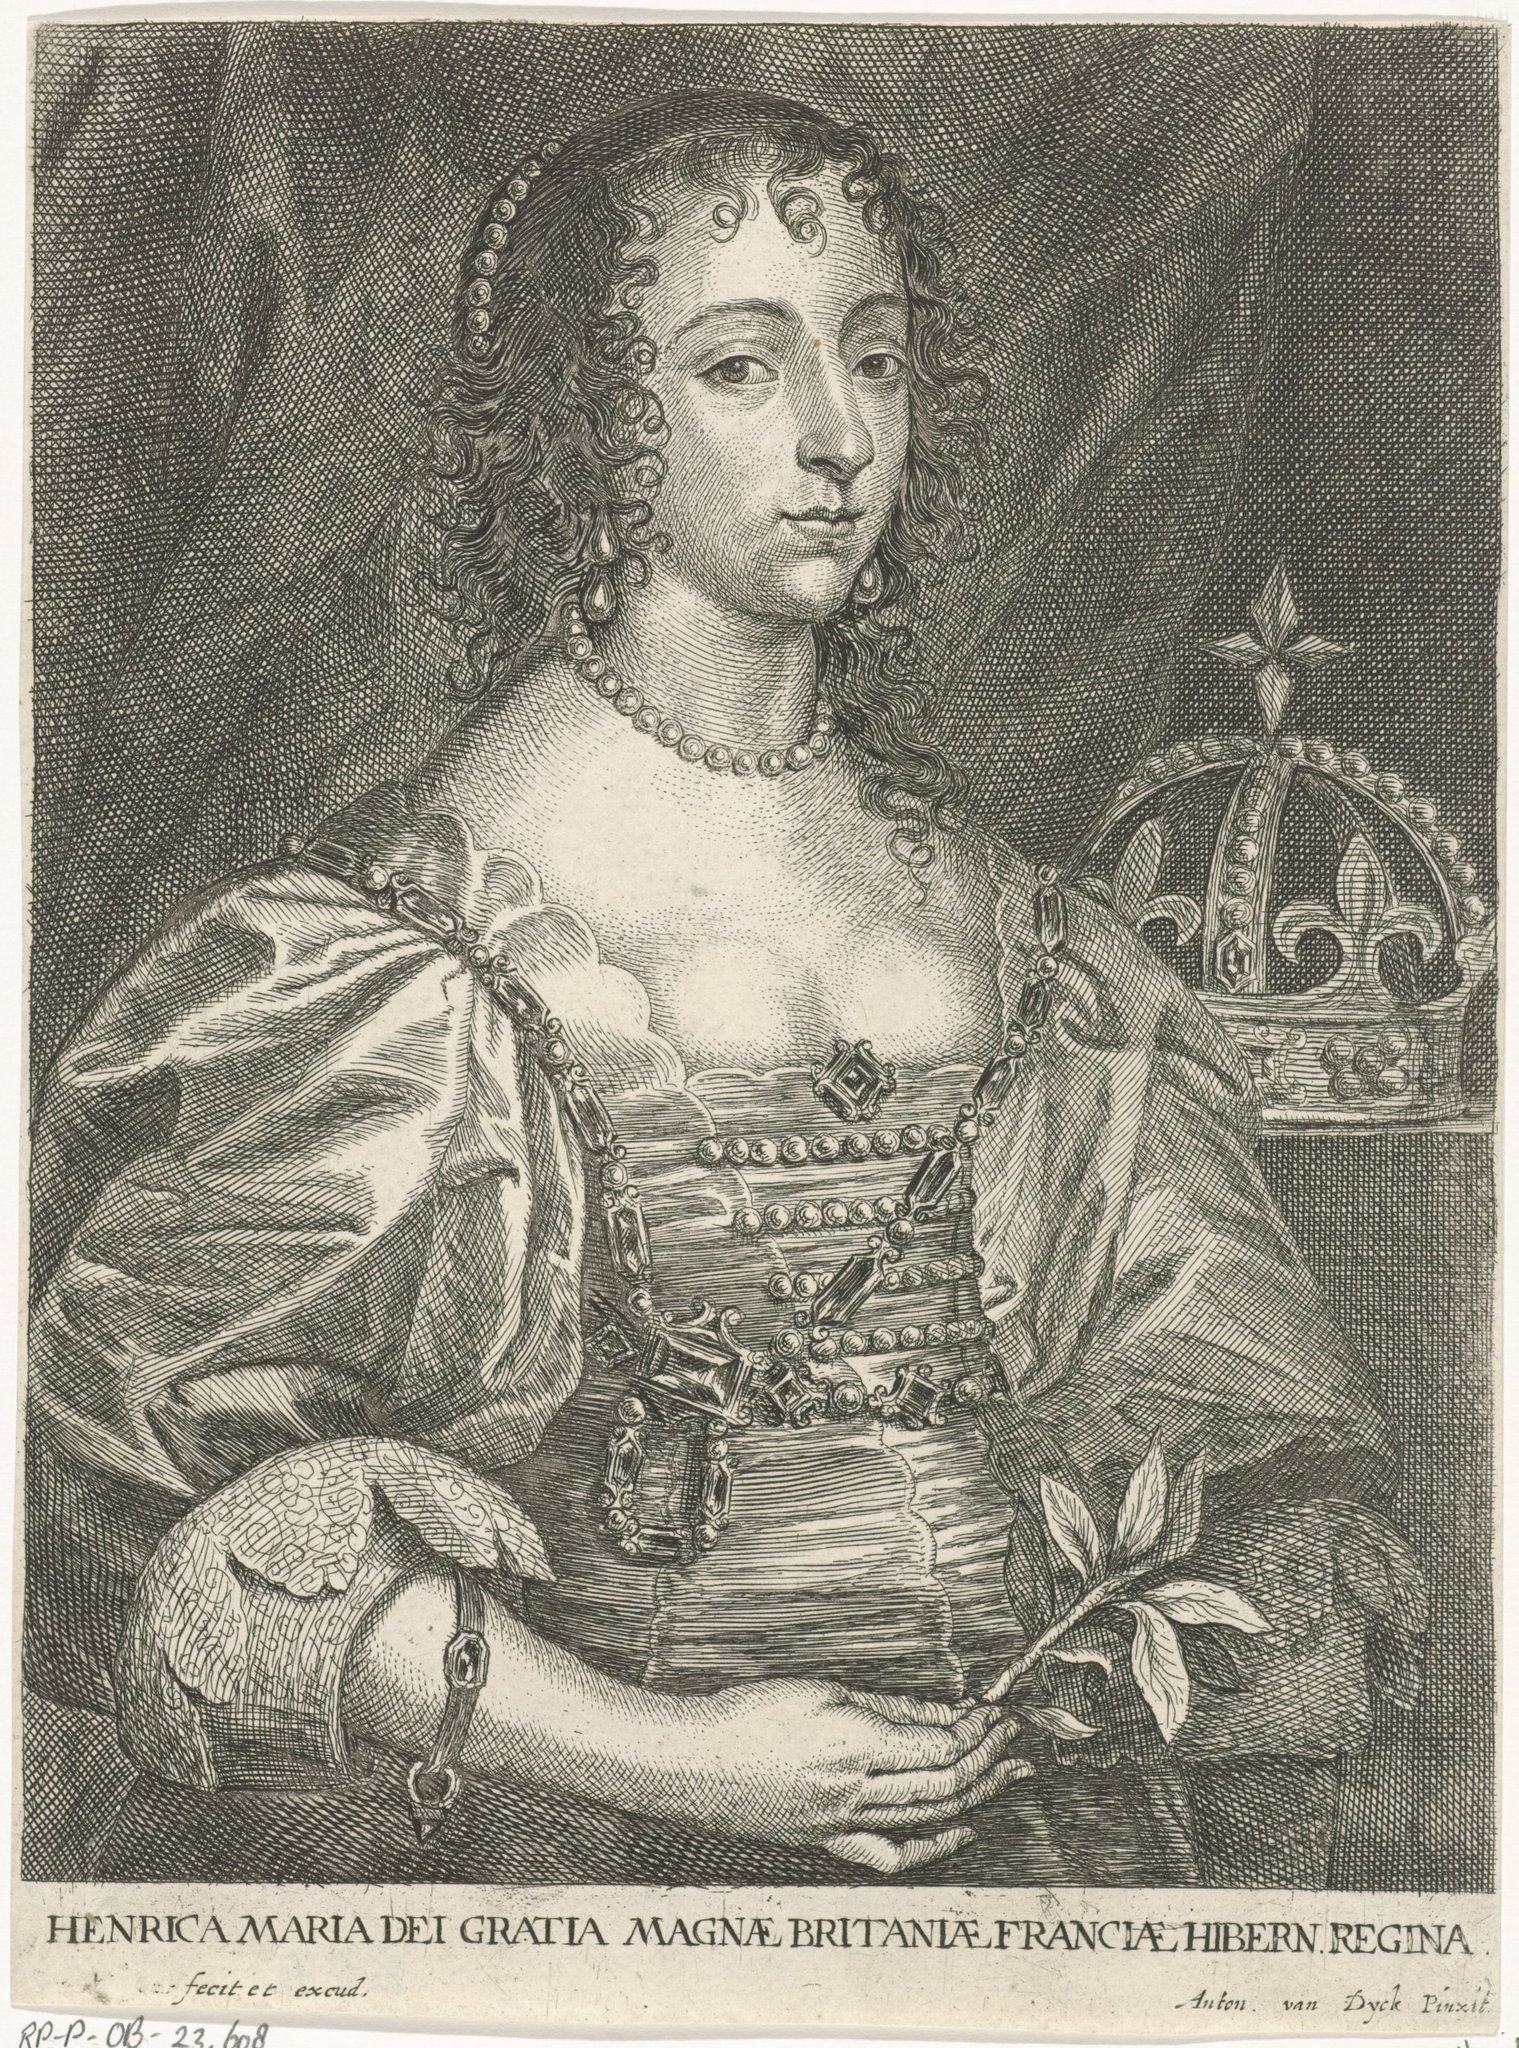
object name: print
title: Portret van Henrietta Maria van Bourbon, koningin van Engeland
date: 1640-1670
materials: paper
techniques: engraving, etching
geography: antwerp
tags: henriëtta maria van frankrijk (koningin van engeland, schotland en ierland), crown (symbol of sovereignty)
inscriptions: collector's mark: Lugt 2228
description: Portret van Henrietta Maria van Bourbon, koningin van Engeland. In haar hand houdt zij een takje met bladeren. Rechts naast haar een kroon.